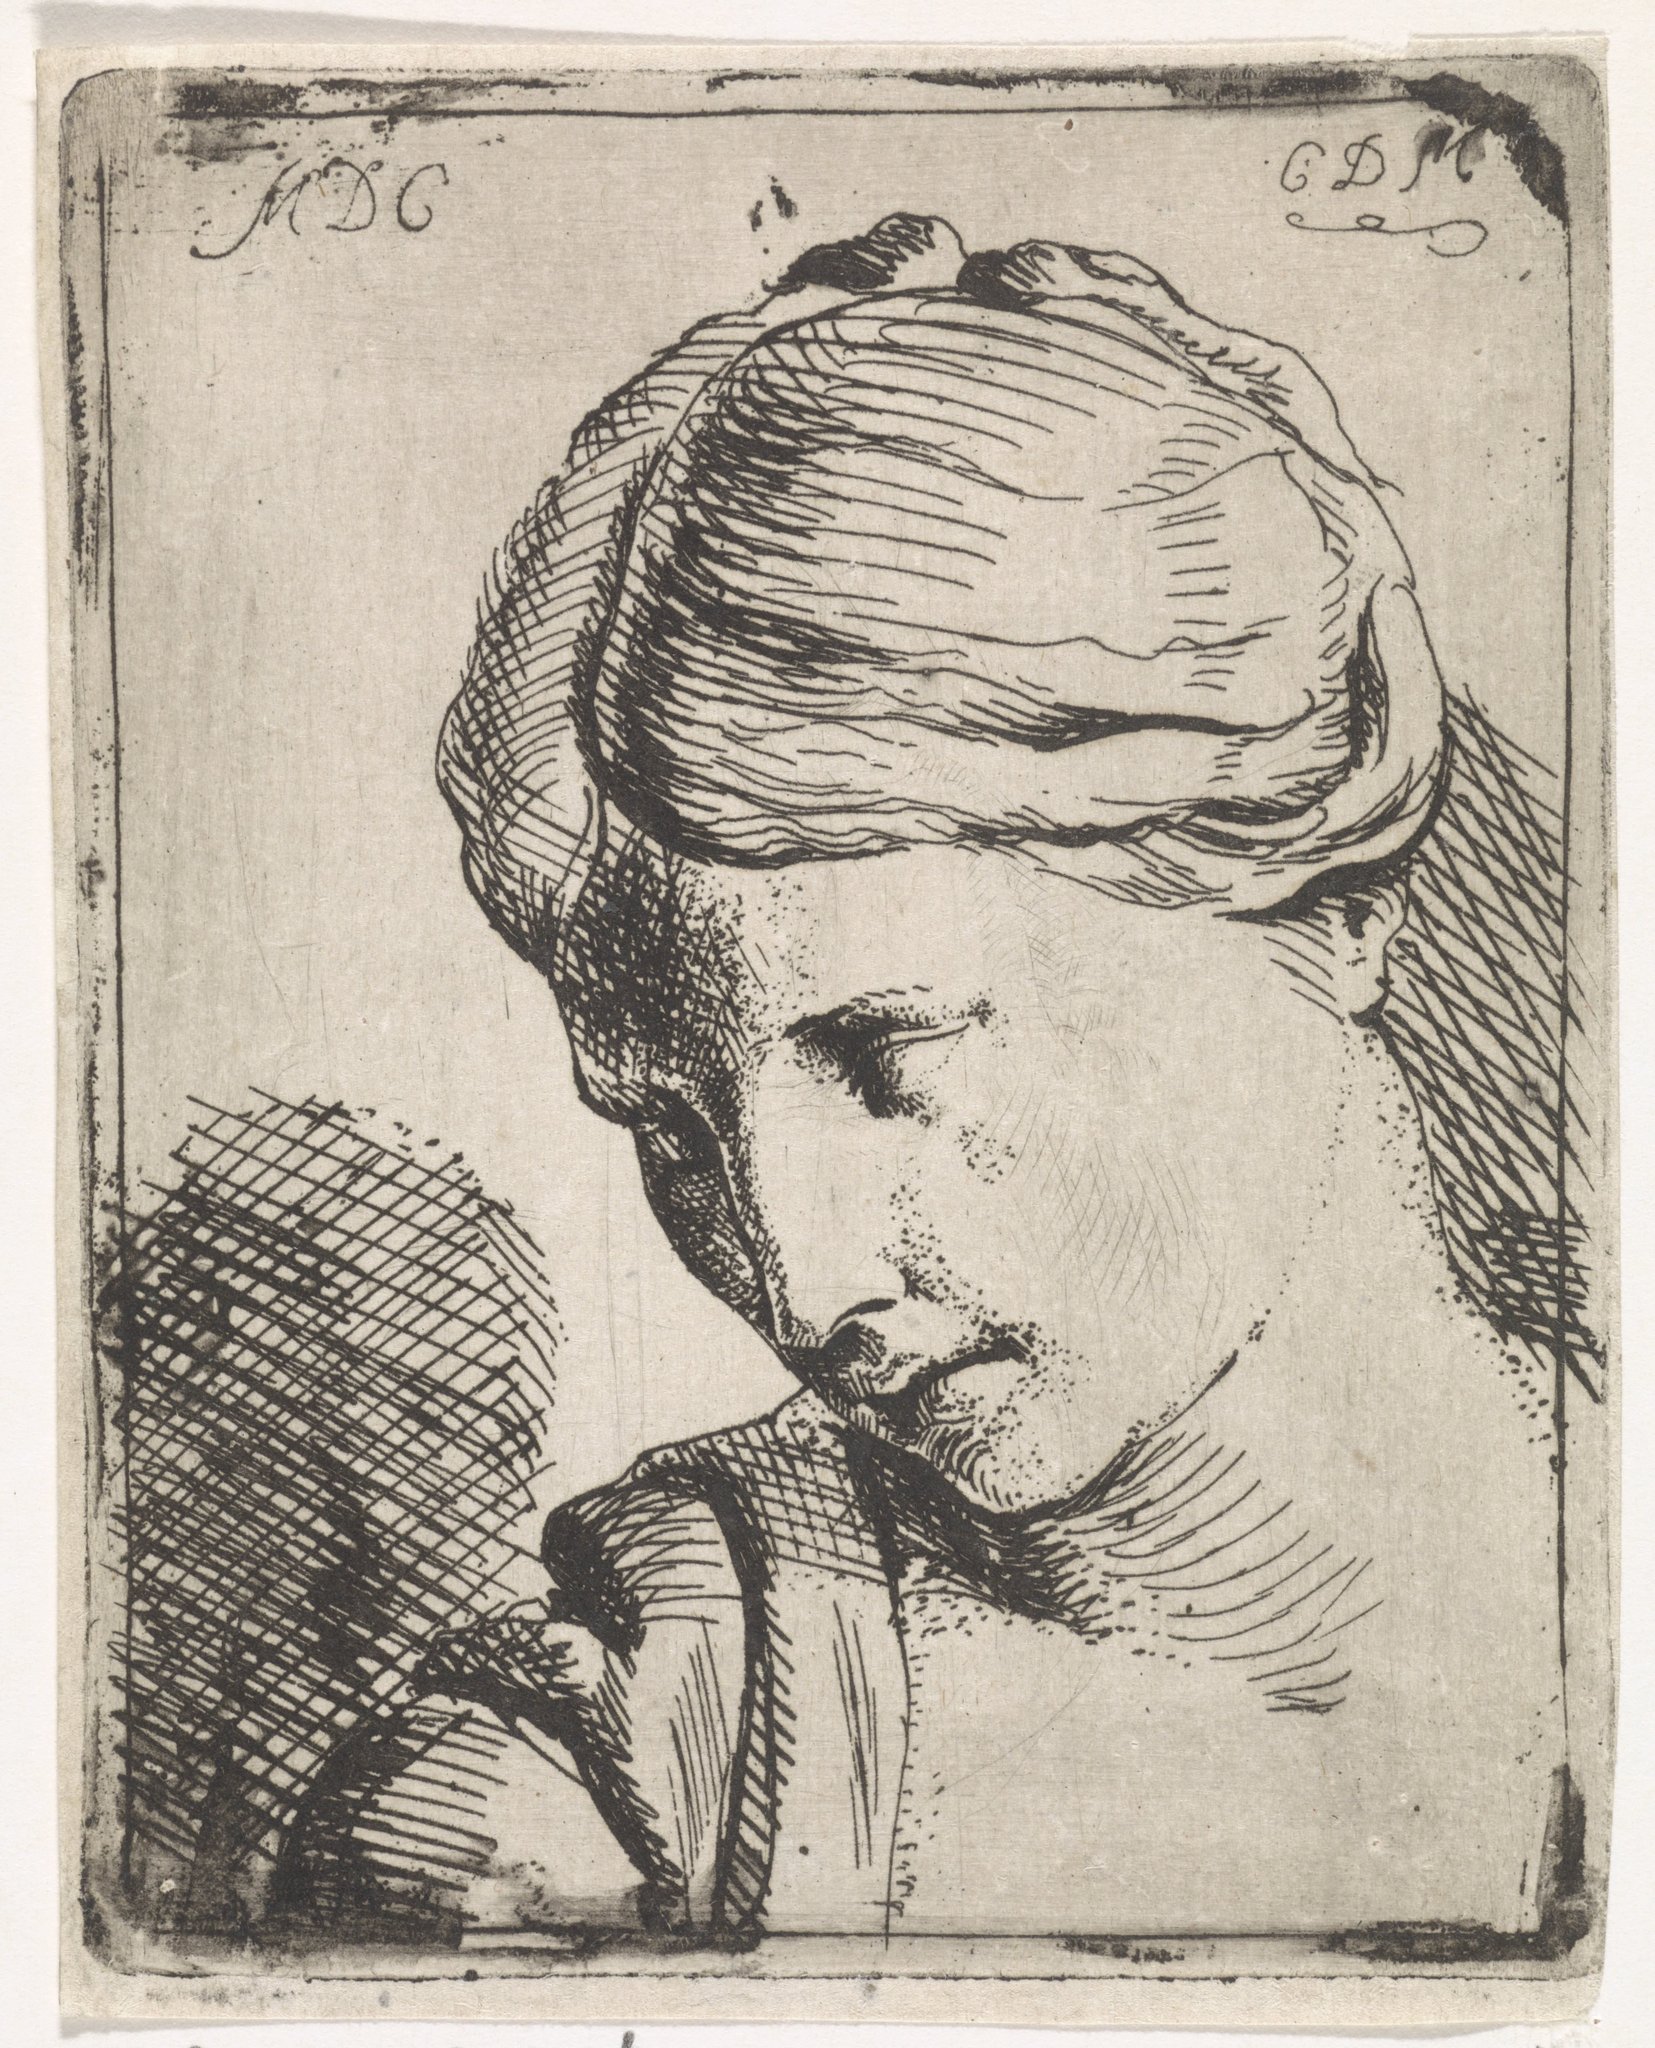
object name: print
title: Jonge vrouw met gebogen hoofd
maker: carel de moor (ii)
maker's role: draughtsman, painter, print maker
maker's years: 1655-1738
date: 1665-1738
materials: paper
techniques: etching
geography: netherlands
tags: head bent forward; bowing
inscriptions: collector's mark: Lugt 240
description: Jonge vrouw met gebogen hoofd, het haar opgestoken.